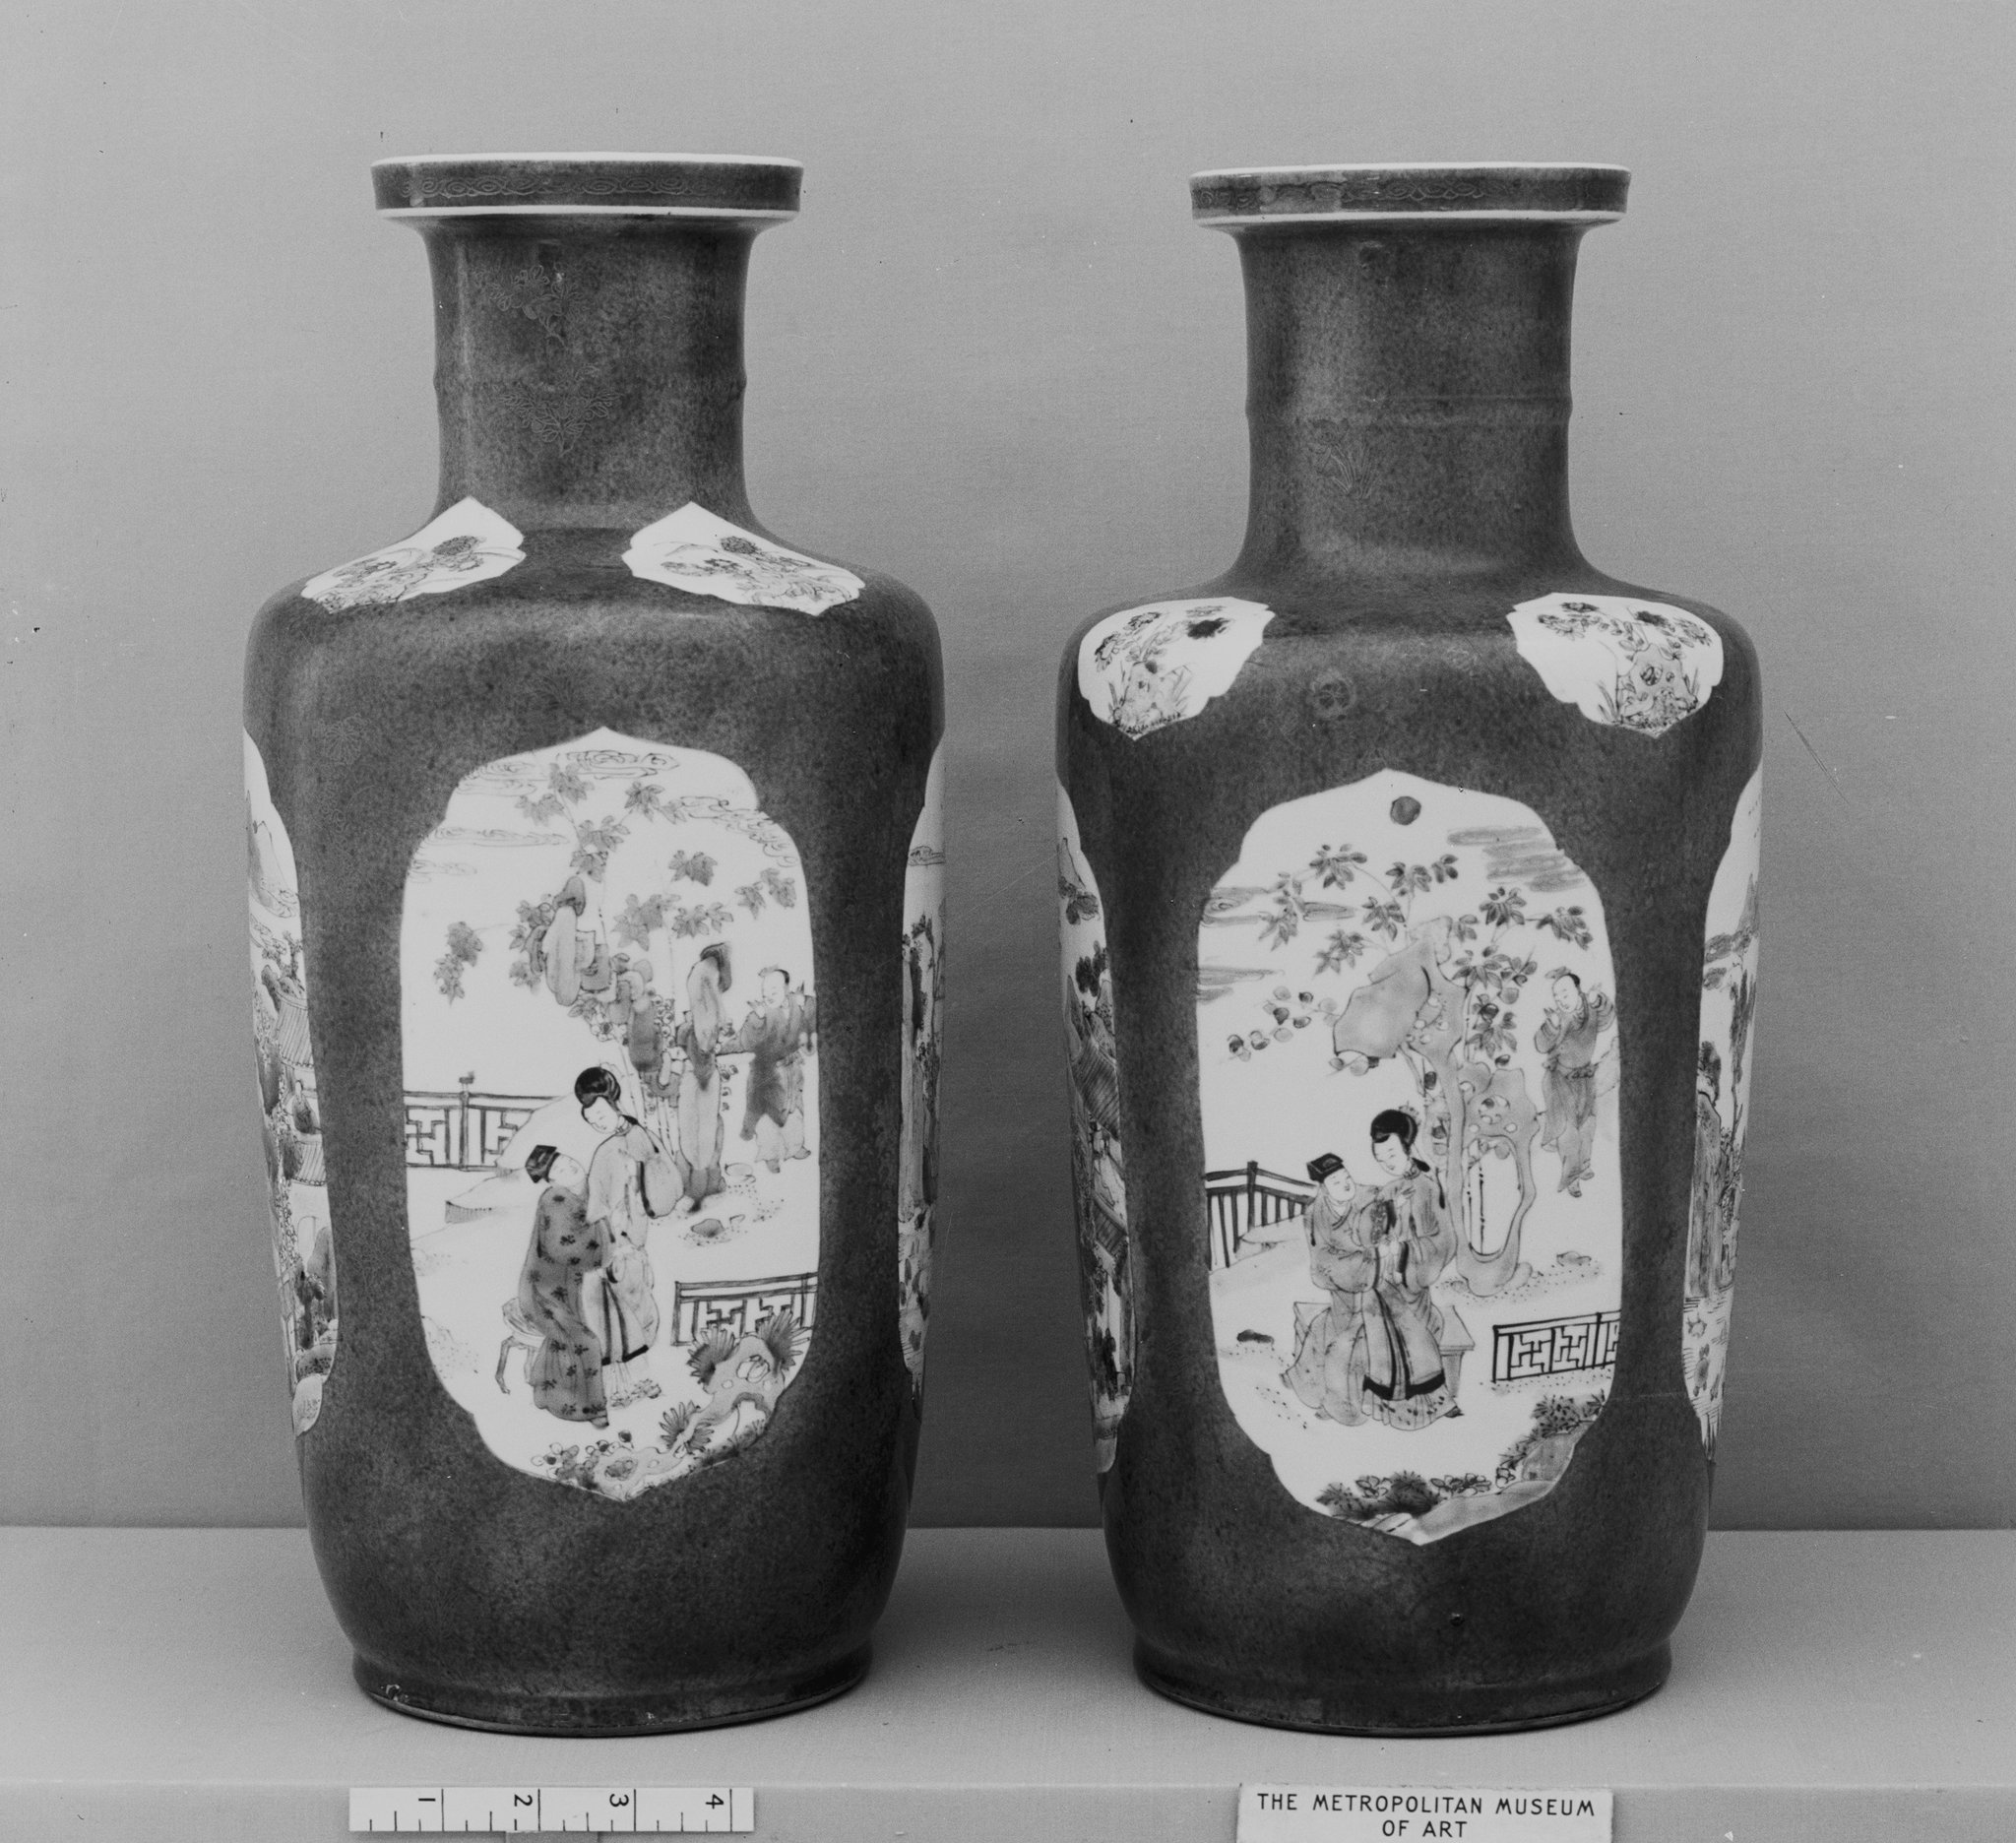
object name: vase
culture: chinese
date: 1662-1722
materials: enamel, porcelain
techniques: painting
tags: men,women,flowers,trees